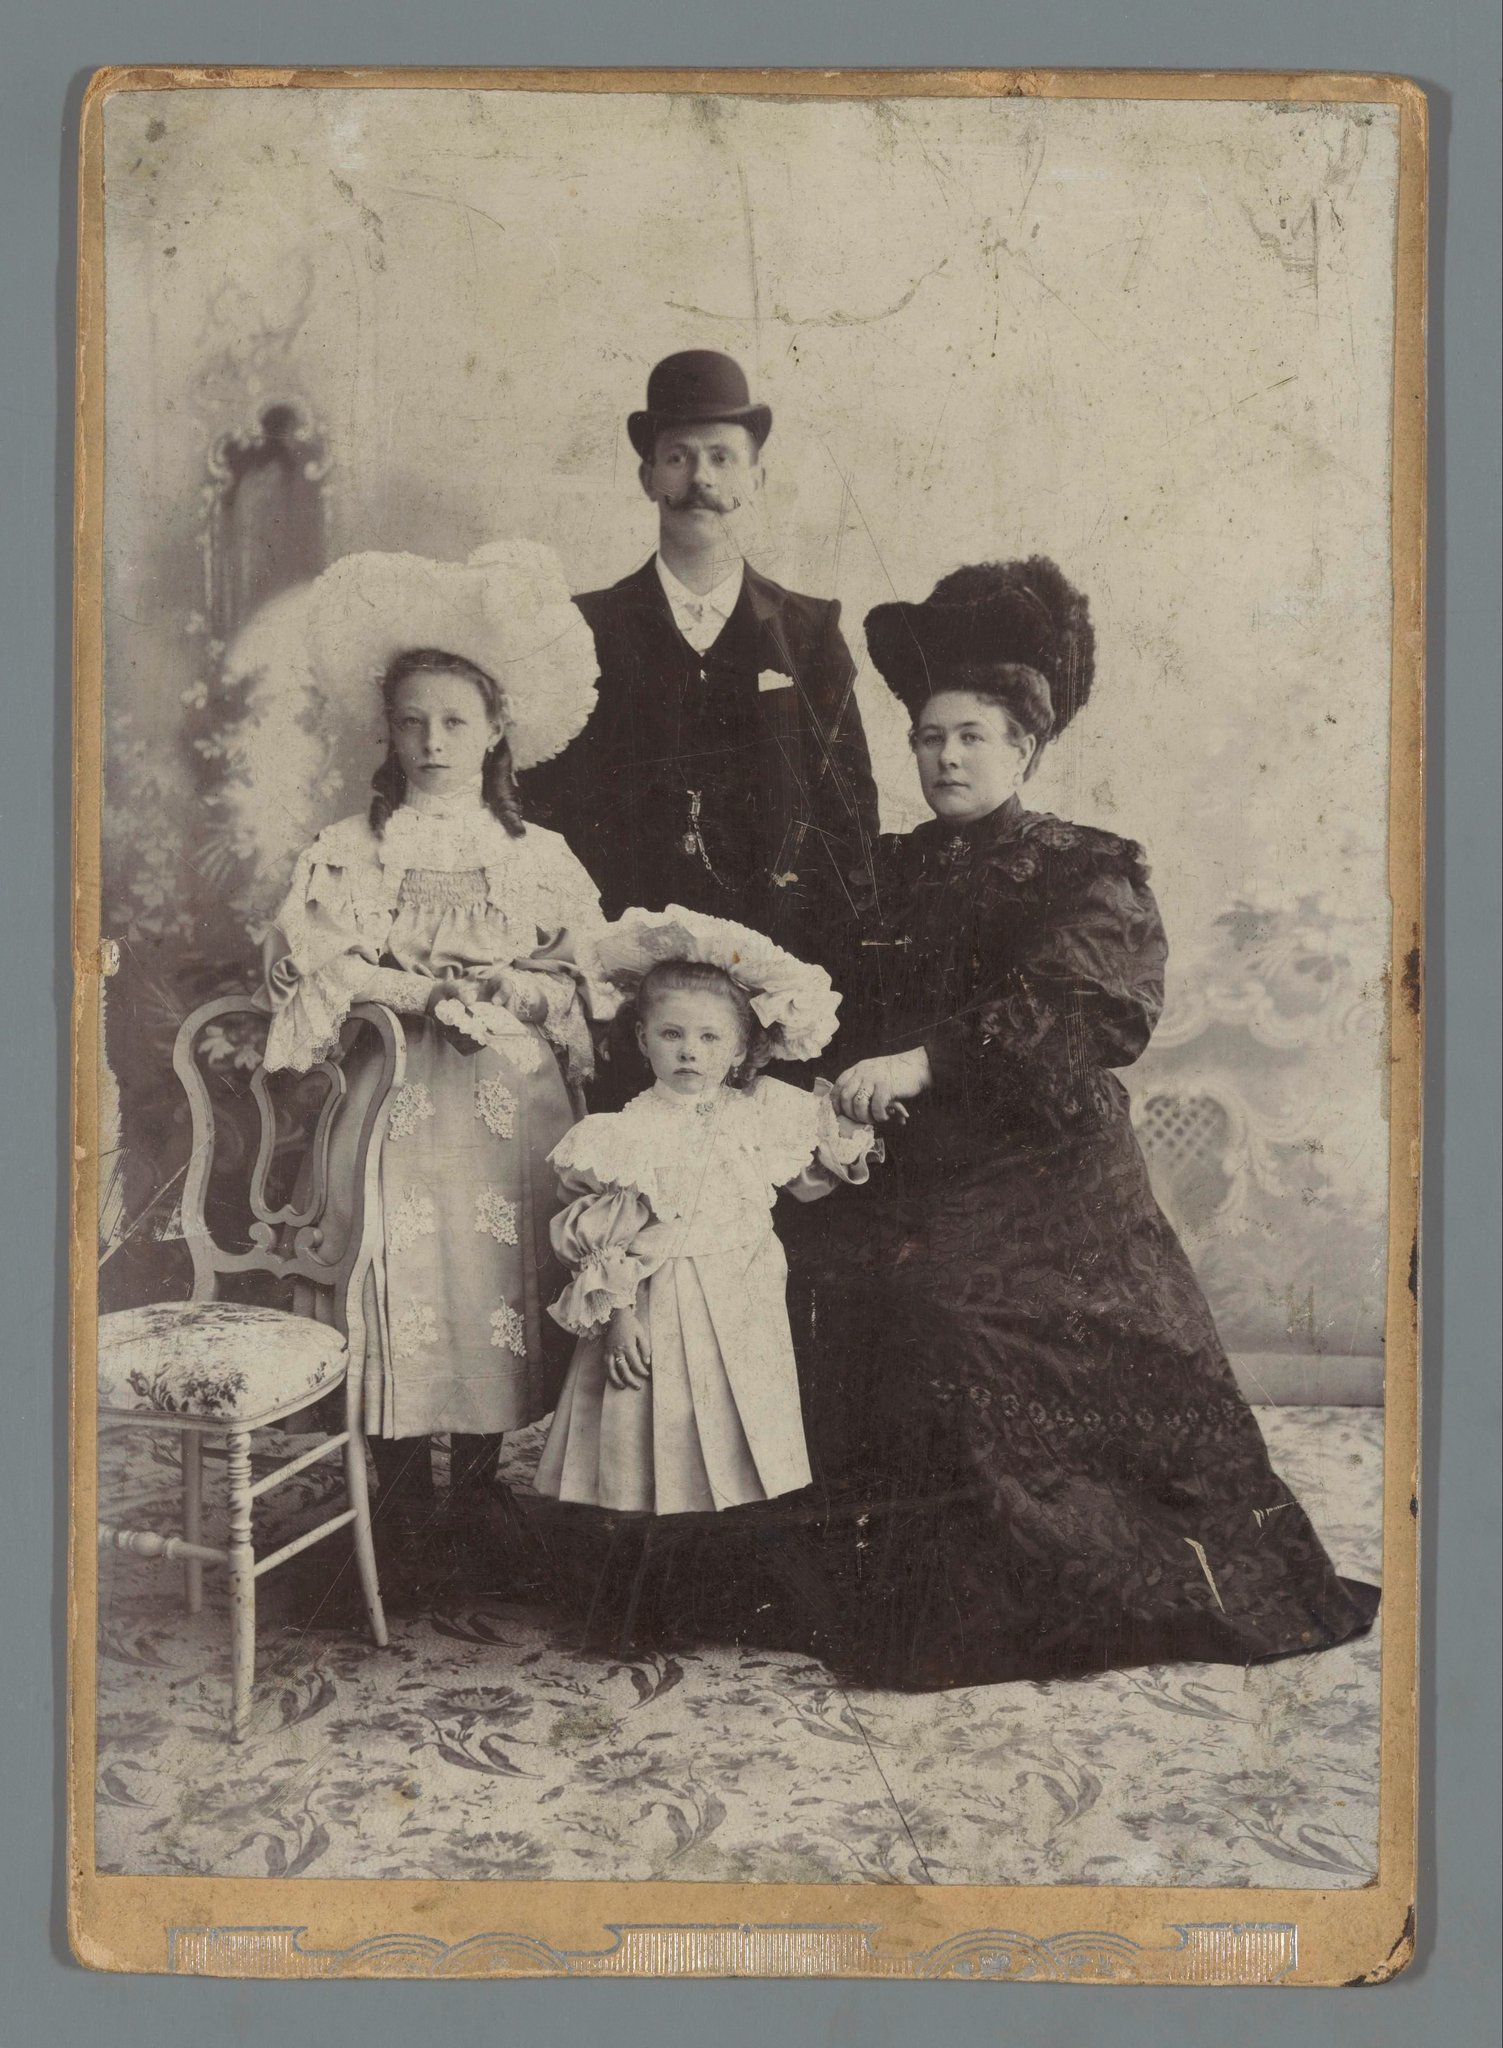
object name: cabinet photograph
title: Familieportret met een man, een vrouw en twee meisjes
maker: Anonymous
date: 1880-1920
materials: cardboard, photographic support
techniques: collodion silver print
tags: family, descendance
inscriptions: name: ‘van Horenb[...]’